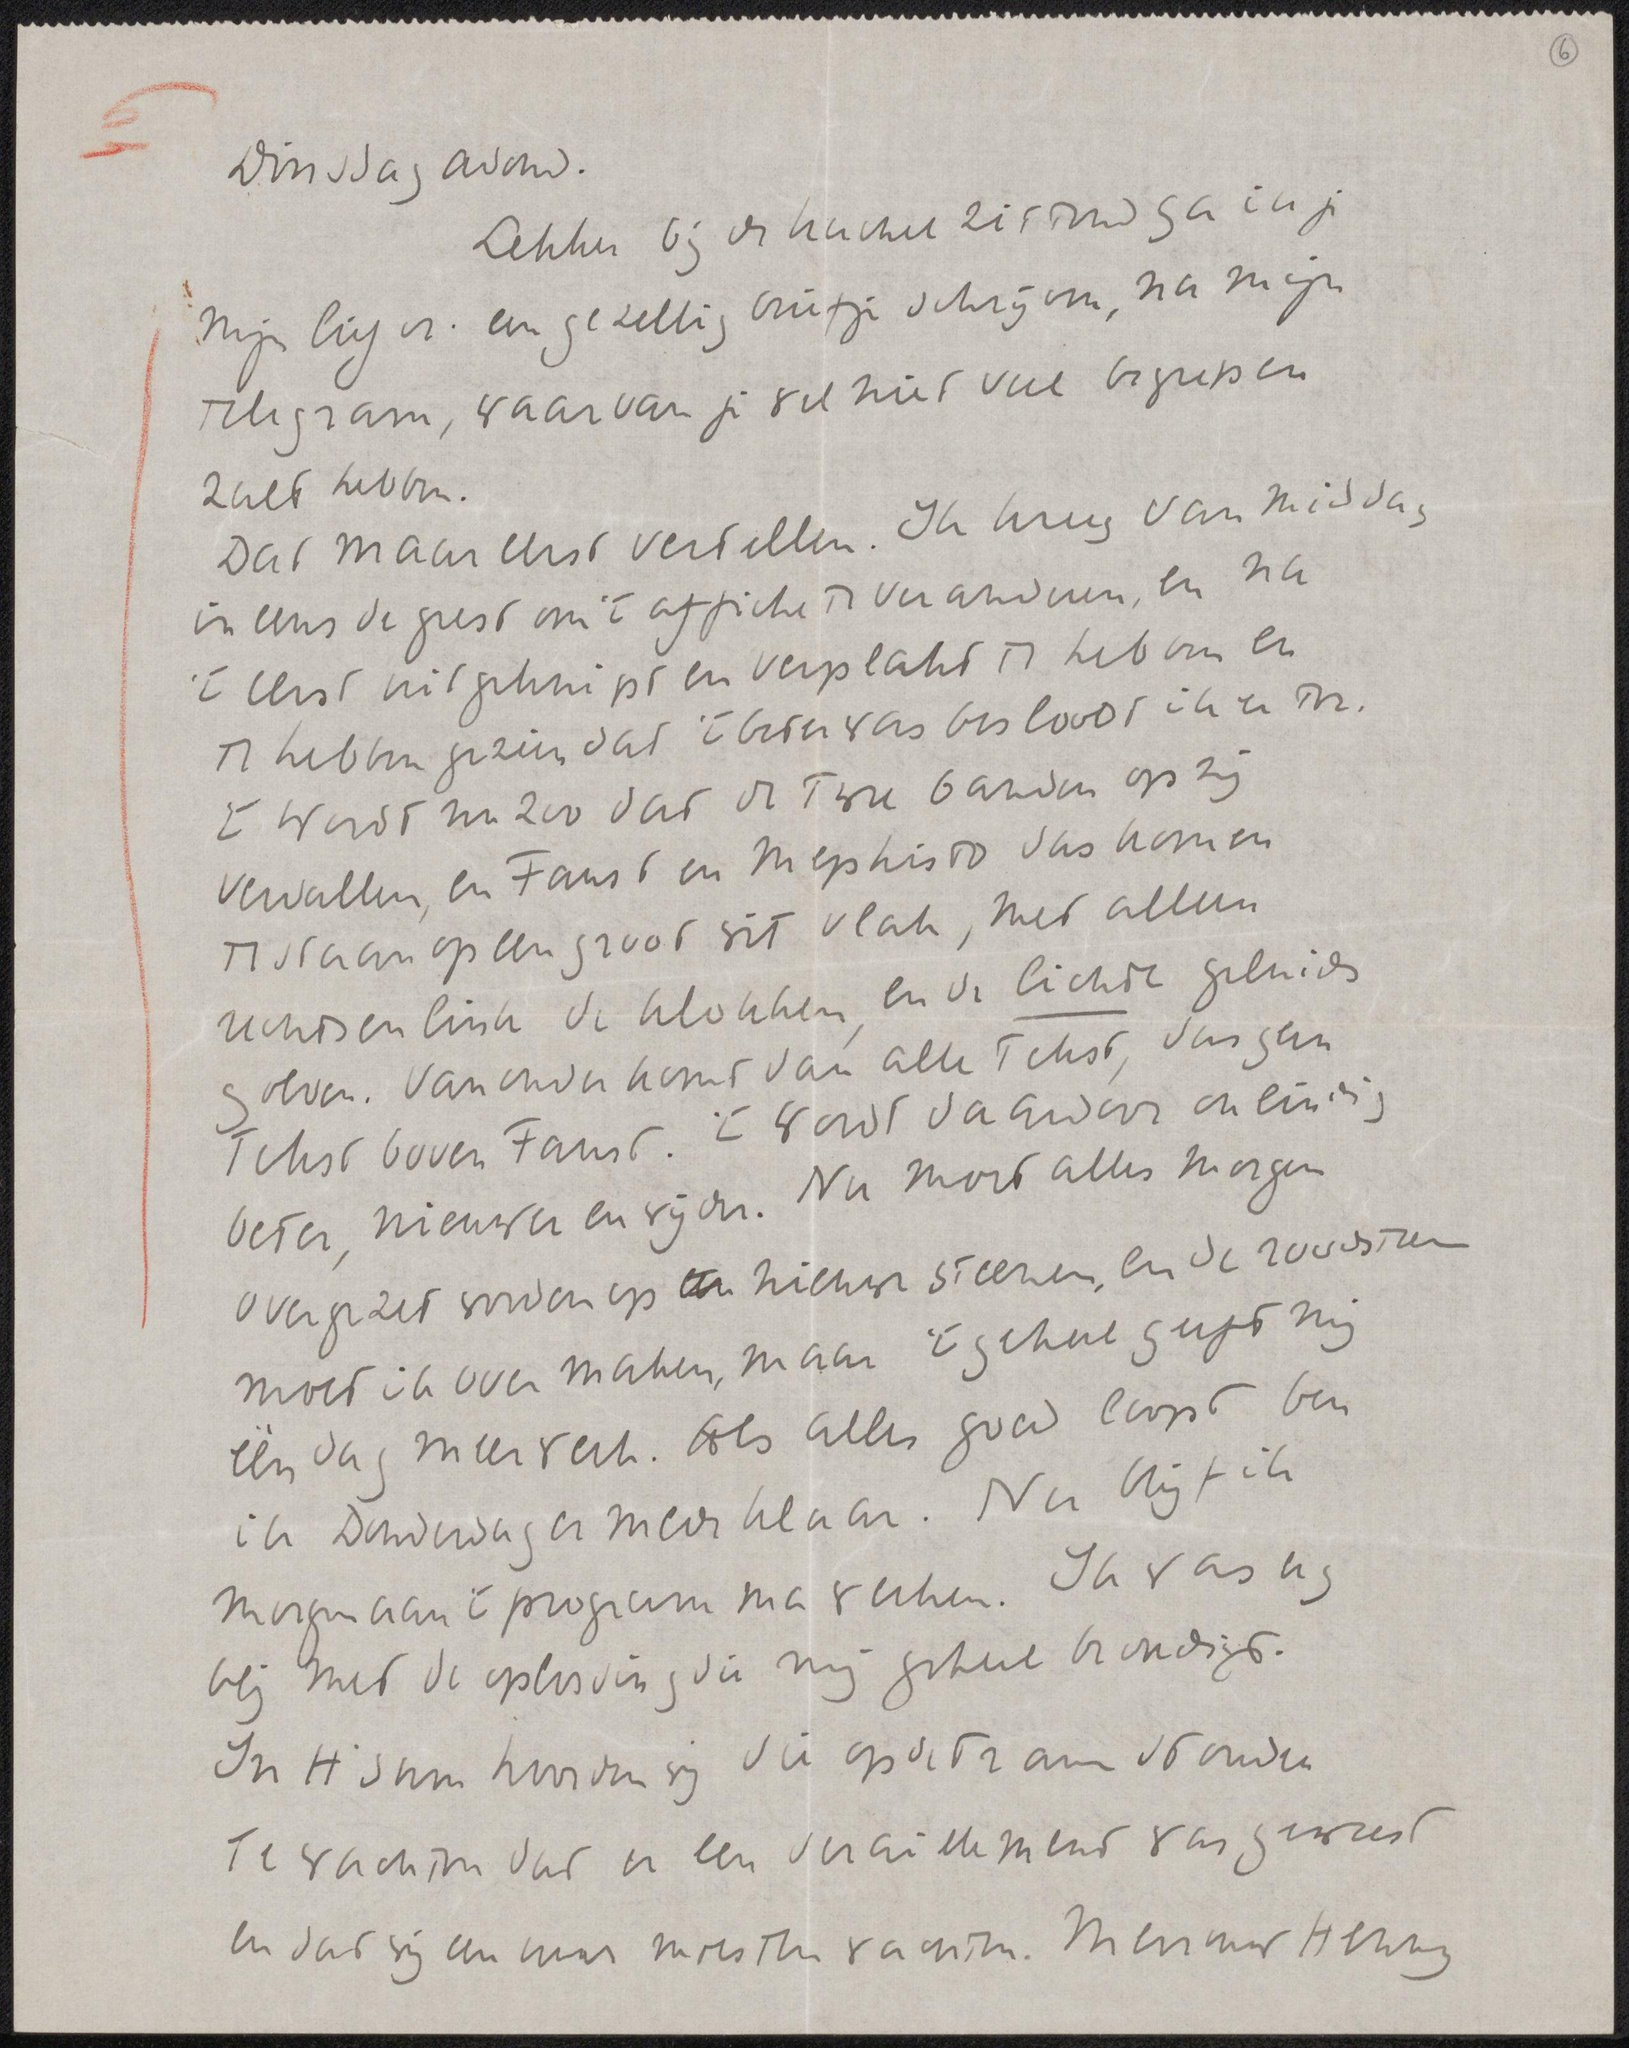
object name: letter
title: Brief aan Ina van Eibergen Santhagens-Waller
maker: richard nicolaüs roland holst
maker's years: 1868-1938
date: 1878-1938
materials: ink, paper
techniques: pen, writing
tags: ina van eibergen santhagens-waller, passions, emotions, affections, the graphic arts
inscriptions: collector's mark: ‘RPK’